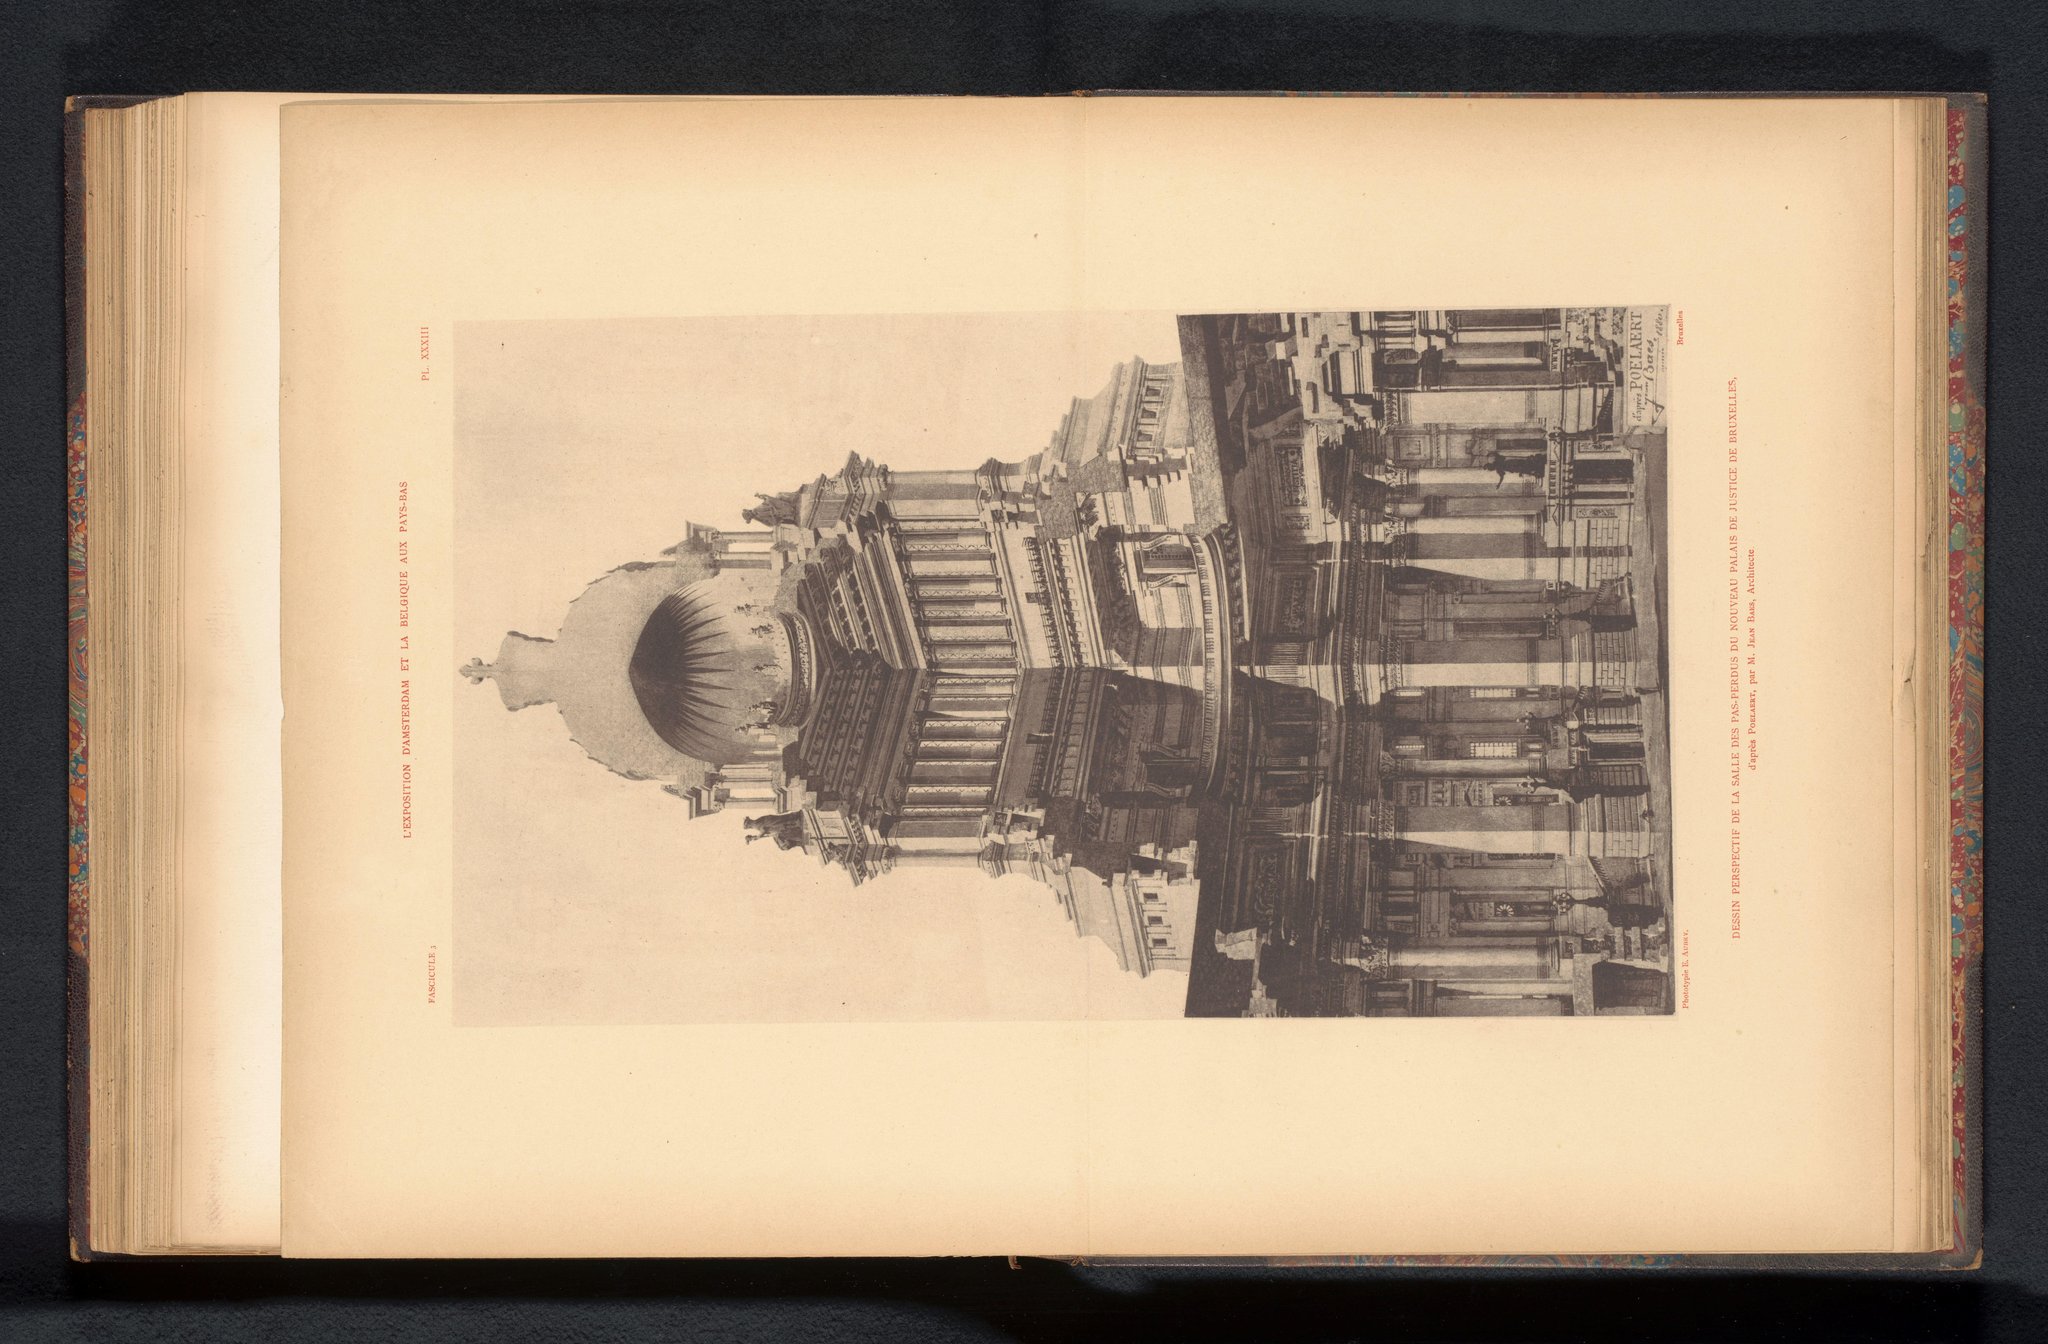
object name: page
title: Reproductie van een prent van een ontwerp voor het nieuwe paleis van justitie van Brussel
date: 1878-1883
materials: paper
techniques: photograph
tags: court building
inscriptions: inscription: ‘La toilette de Vénus’, inscription: ‘Fascicule 3/ PL. XXXIII’